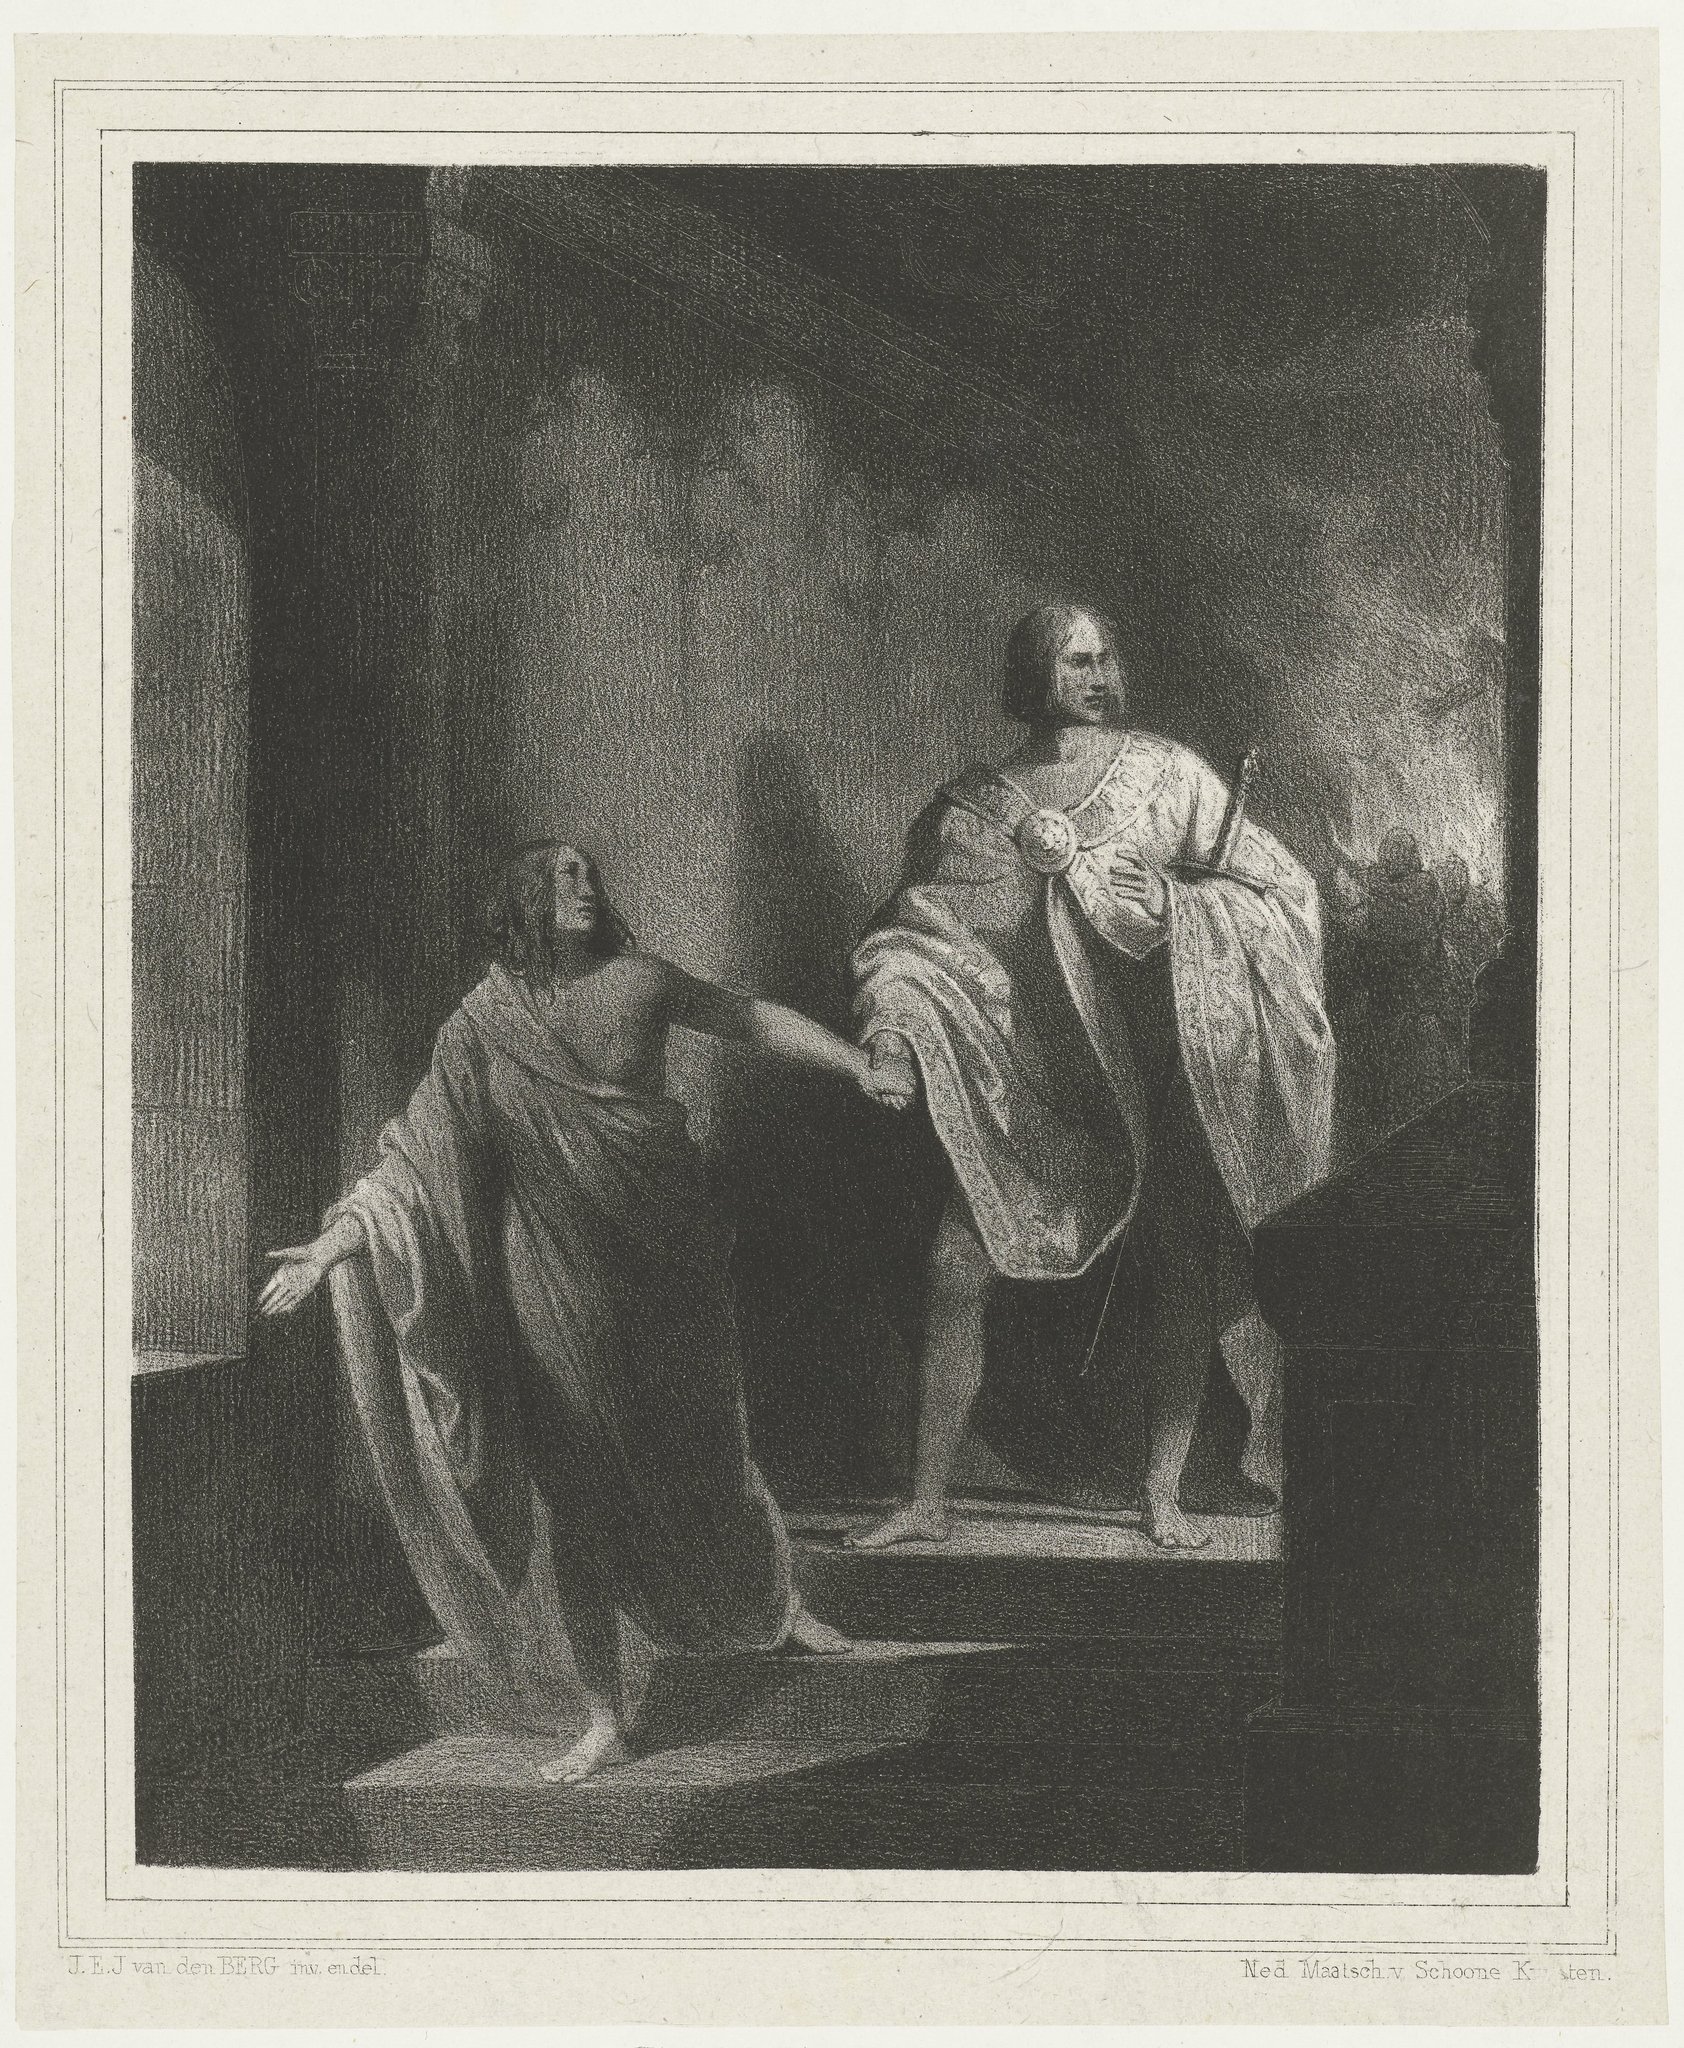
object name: history print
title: Graaf Willem II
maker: jacobus everhardus josephus van den berg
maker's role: draughtsman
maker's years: 1802-1861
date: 1840-1843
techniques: printmaking, lithograph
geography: netherlands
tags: netherlands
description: Graaf van Holland Willem II wordt heimelijk door vrouw door een gang weggevoerd, vermoedelijk om te ontvluchten. Onbekende gebeurtenis, ca. 1250.